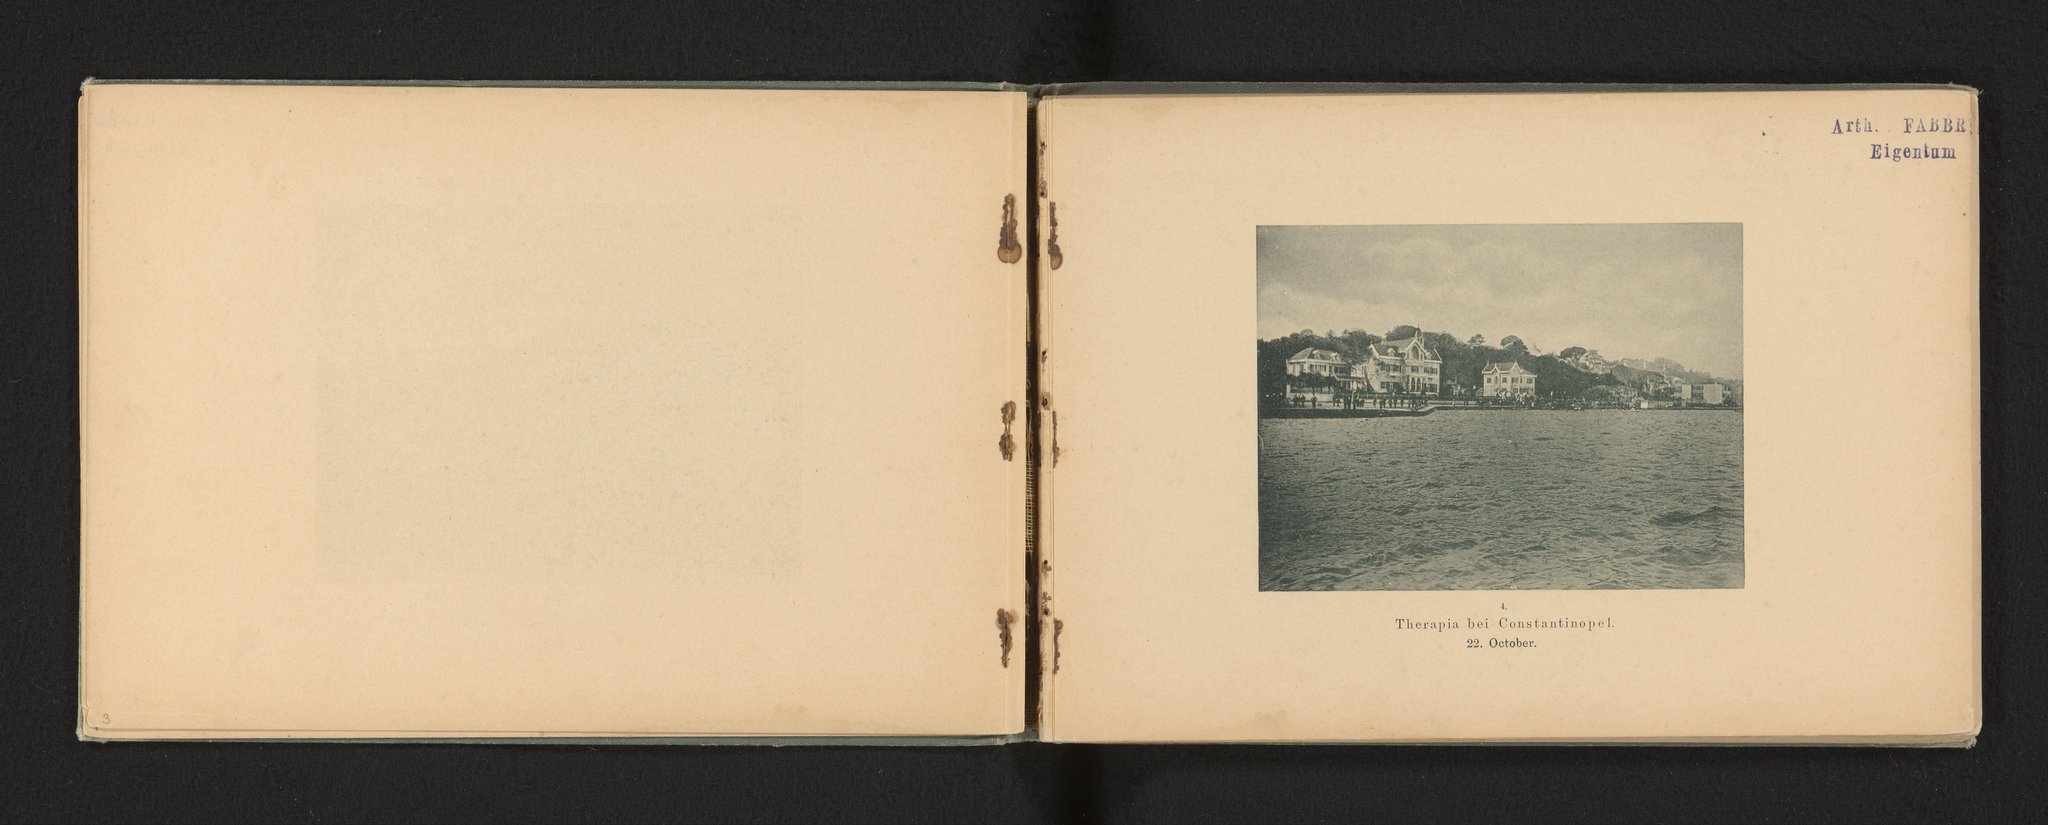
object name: page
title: Gezicht op de wijk Tarabya aan de Bosporus in Istanbul, Turkije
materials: paper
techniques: photograph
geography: istanbul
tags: canals, waters (in city), prospect of city, town panorama, silhouette of city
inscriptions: collector's mark: ‘Arth. FABBR[I]/ Eigentum’, number: ‘4.’